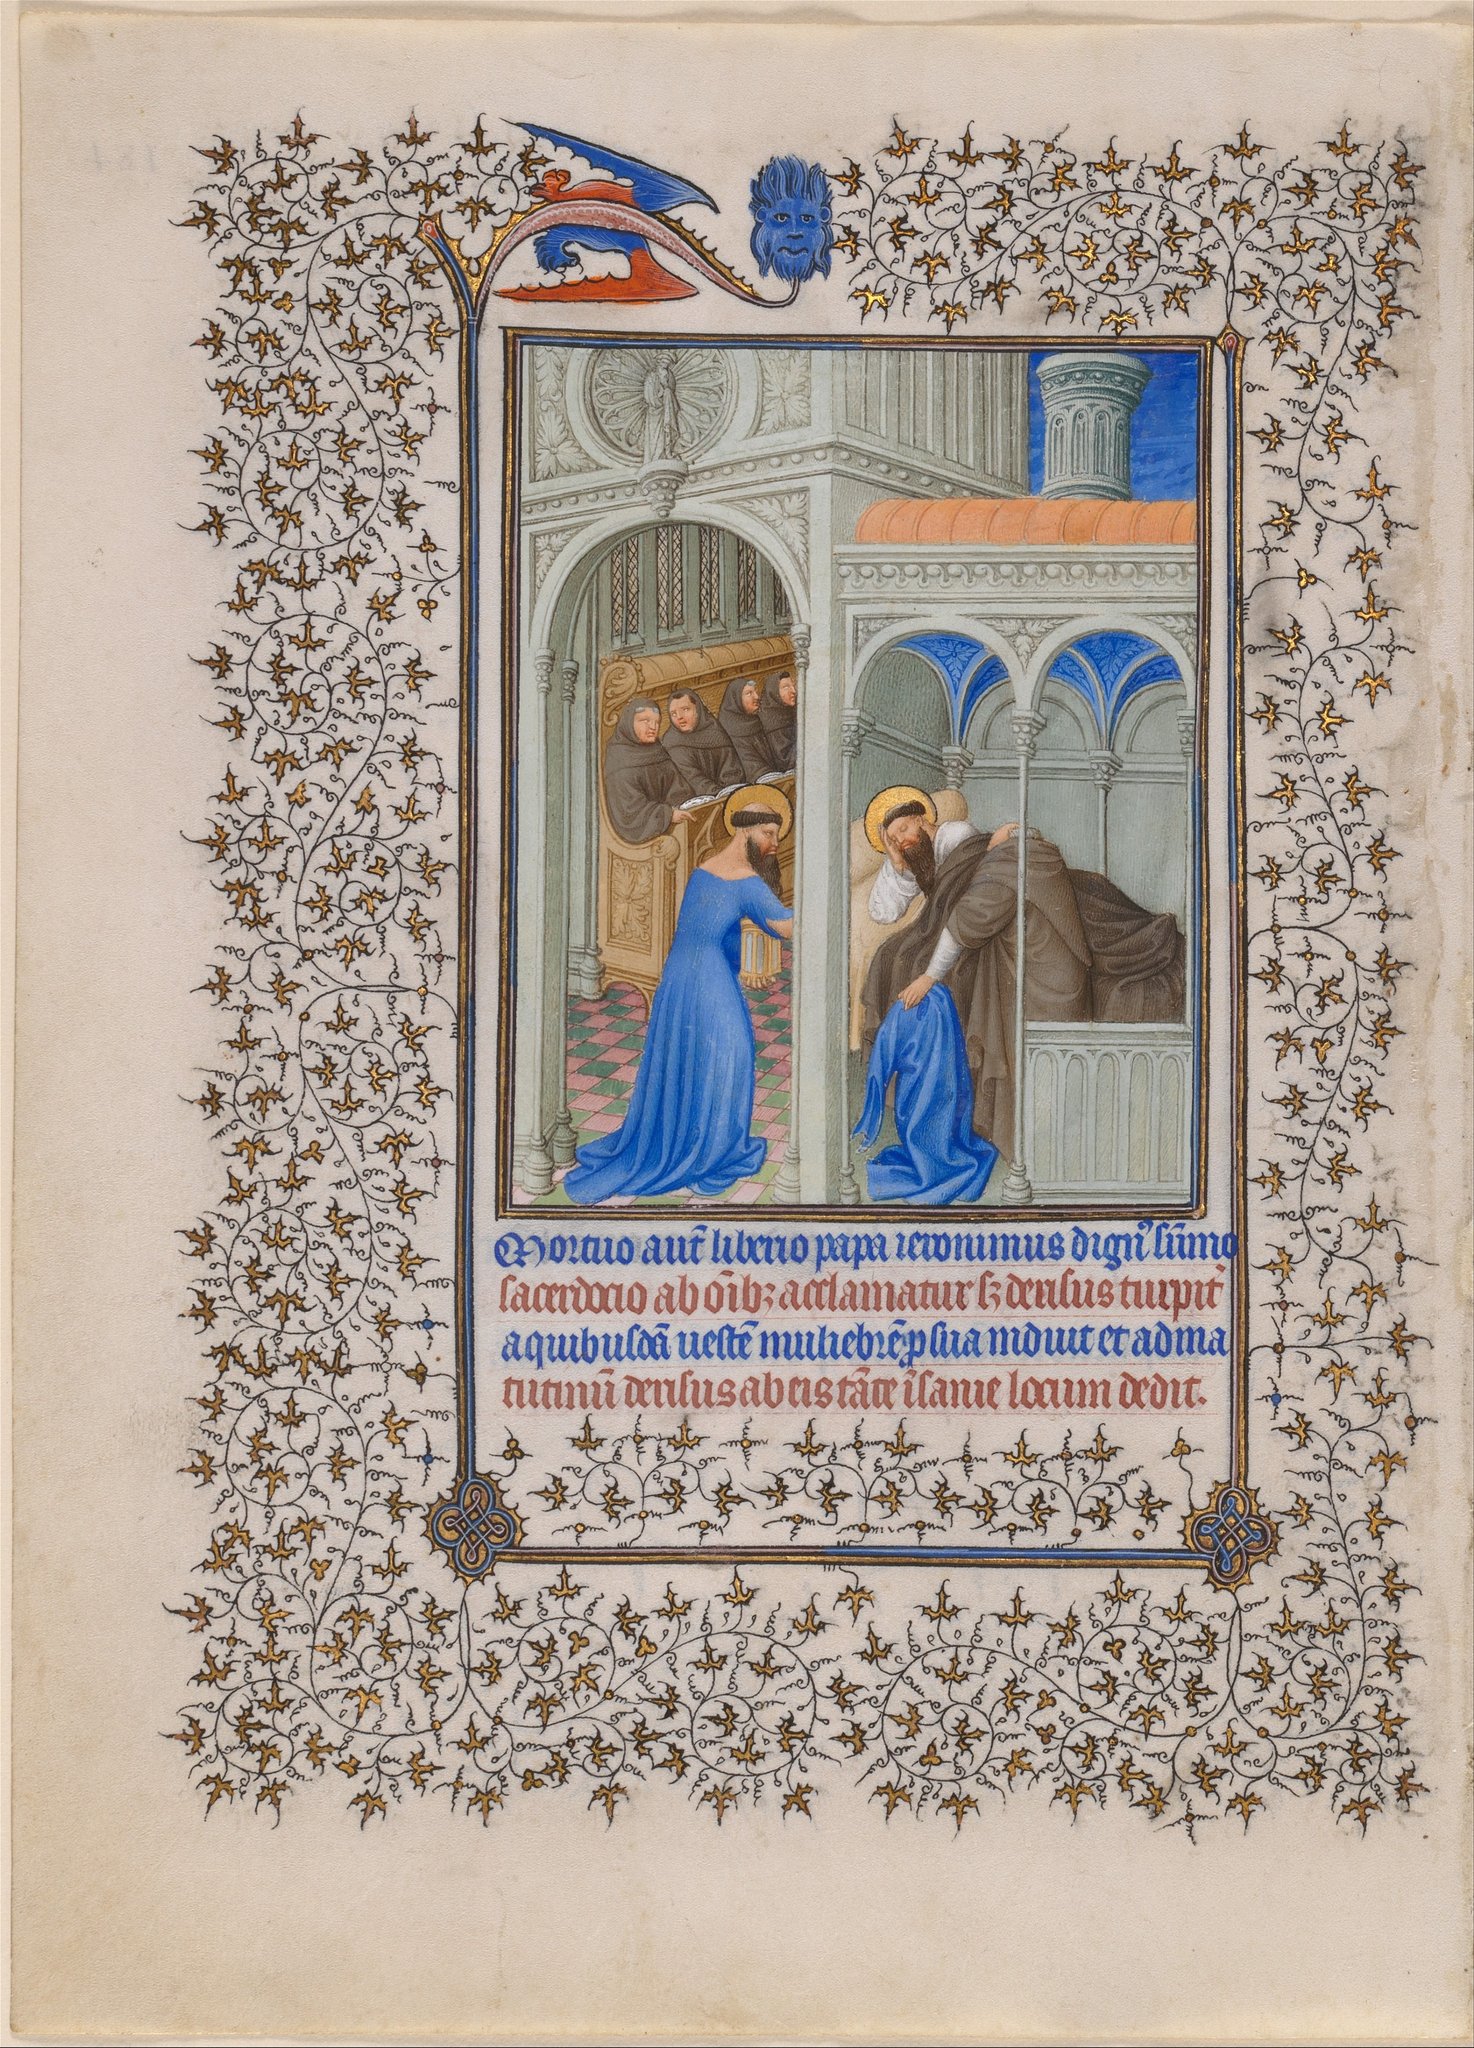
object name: book of hour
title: The Belles Heures of Jean de France, duc de Berry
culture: french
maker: the limbourg brothers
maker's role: artist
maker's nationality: franco-netherlandish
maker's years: 1399-1416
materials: gold, ink, paint, parchment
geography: france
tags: angels,christ,virgin mary,adoration of the magi,annunciation,assumption of the virgin,crucifixion,agony in the garden